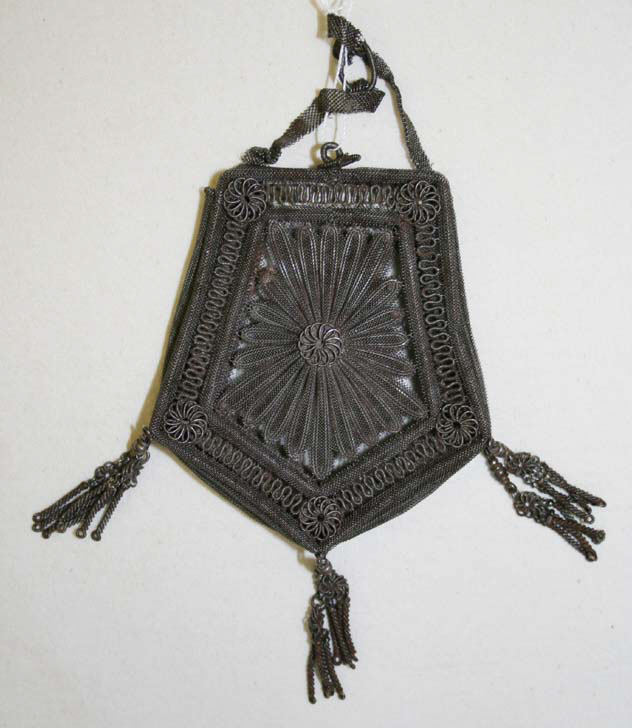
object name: purse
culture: french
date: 1801-1833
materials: steel